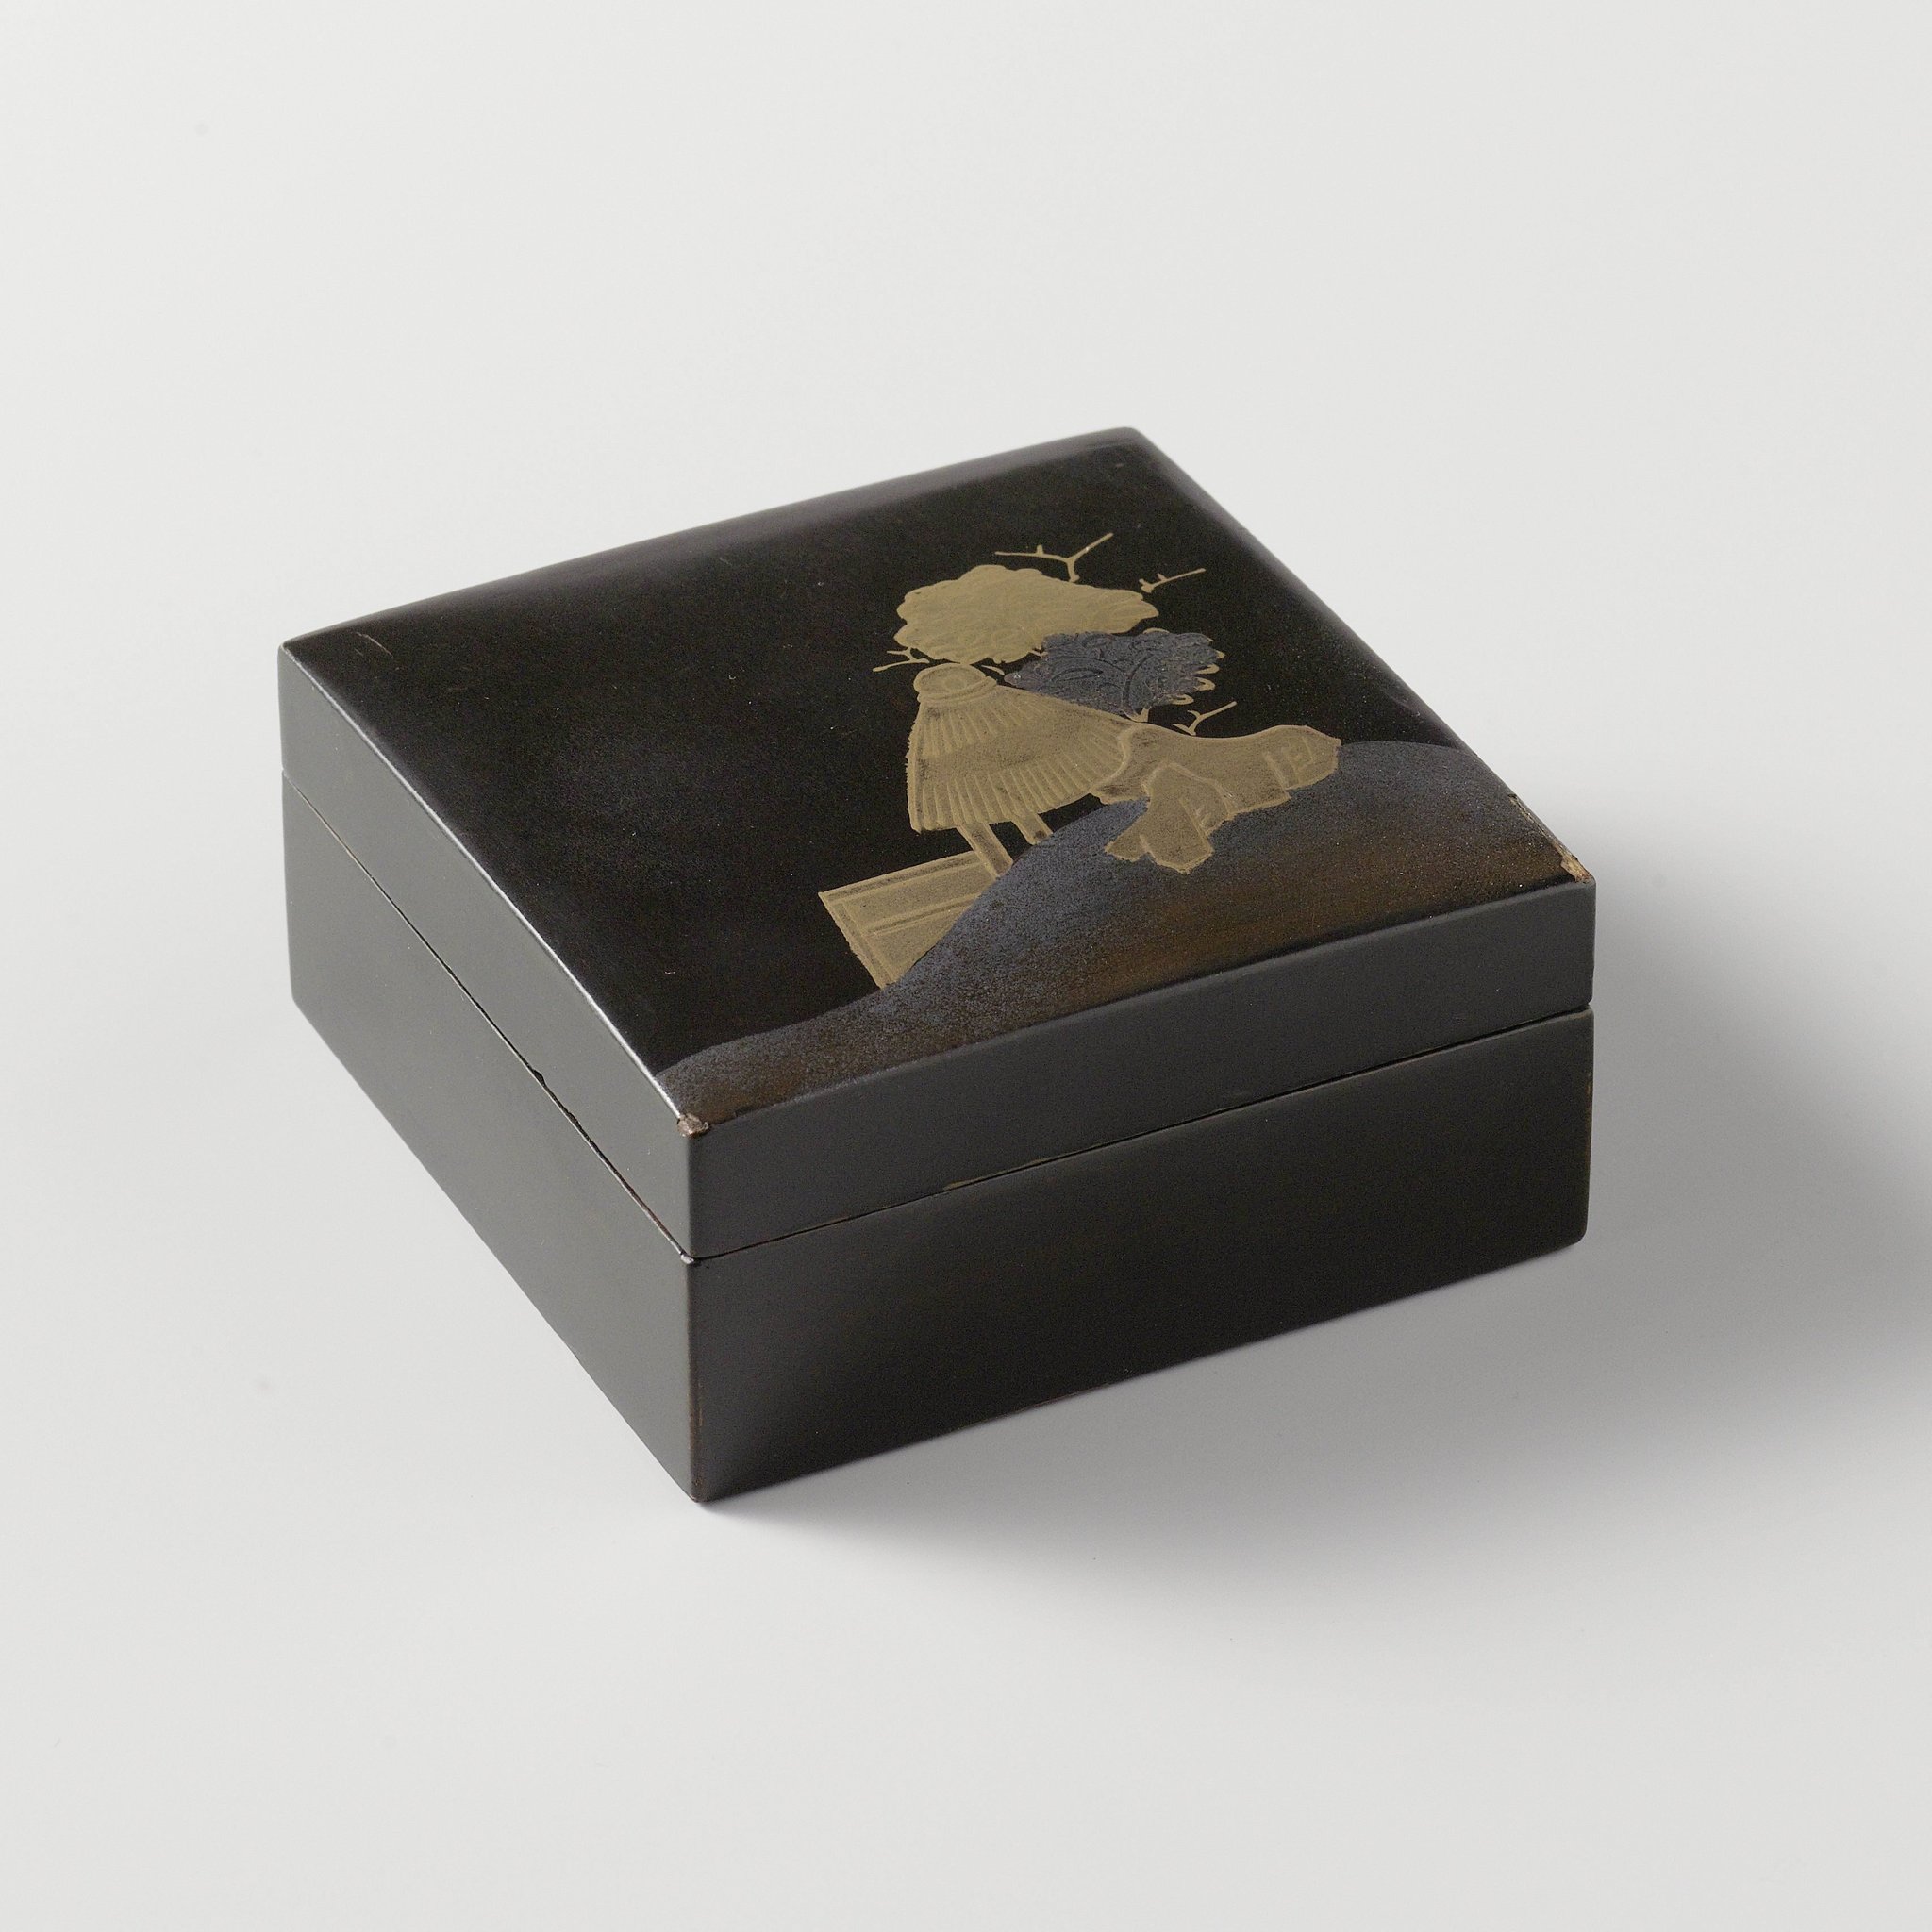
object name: box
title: Vierkant doosje met een landschap in goud op een zwarte ondergrond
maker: Anonymous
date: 1750-1800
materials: lacquer, wood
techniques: lacquer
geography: japan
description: Vierkante doos met een enigszins bolle deksel. Op de buitenzijde schetmatige waterlandschappen in makie op een zwarte ondergrond. Aan de binnenzijde nashiji.